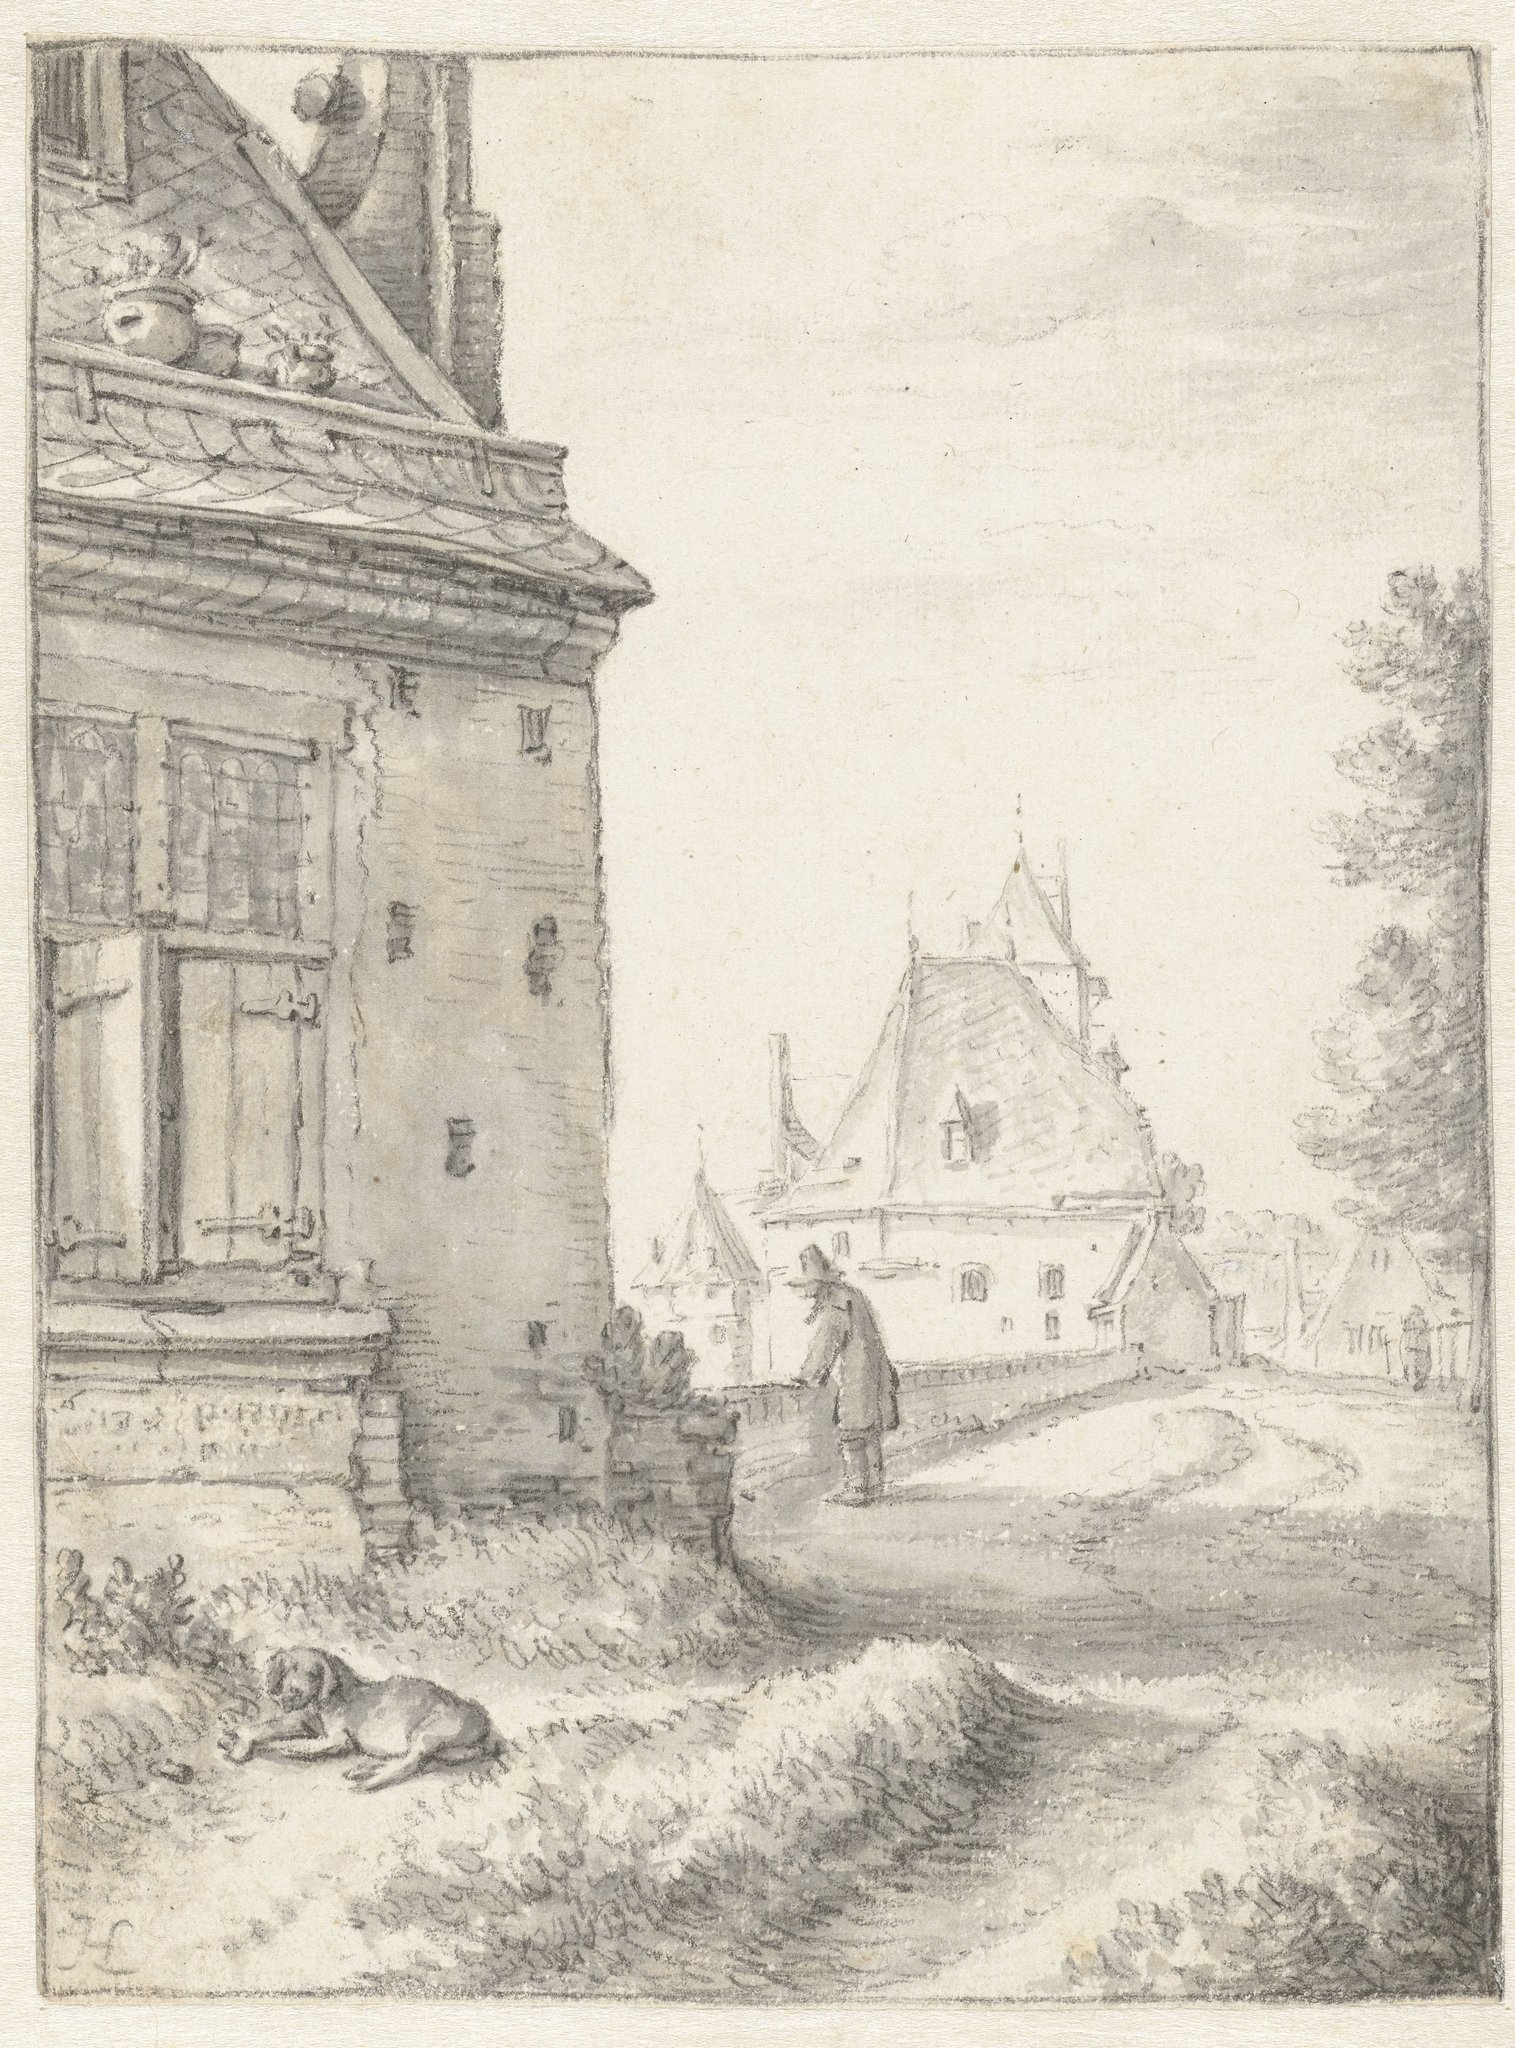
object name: drawing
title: Gezicht vanaf de stadswal van Utrecht met op de achtergrond de Plompetoren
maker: herman saftleven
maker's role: draughtsman, painter, print maker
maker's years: 1609-1685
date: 1619-1685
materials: chalk, paper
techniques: brush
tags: towers ~ fortified city, city-walls, utrecht